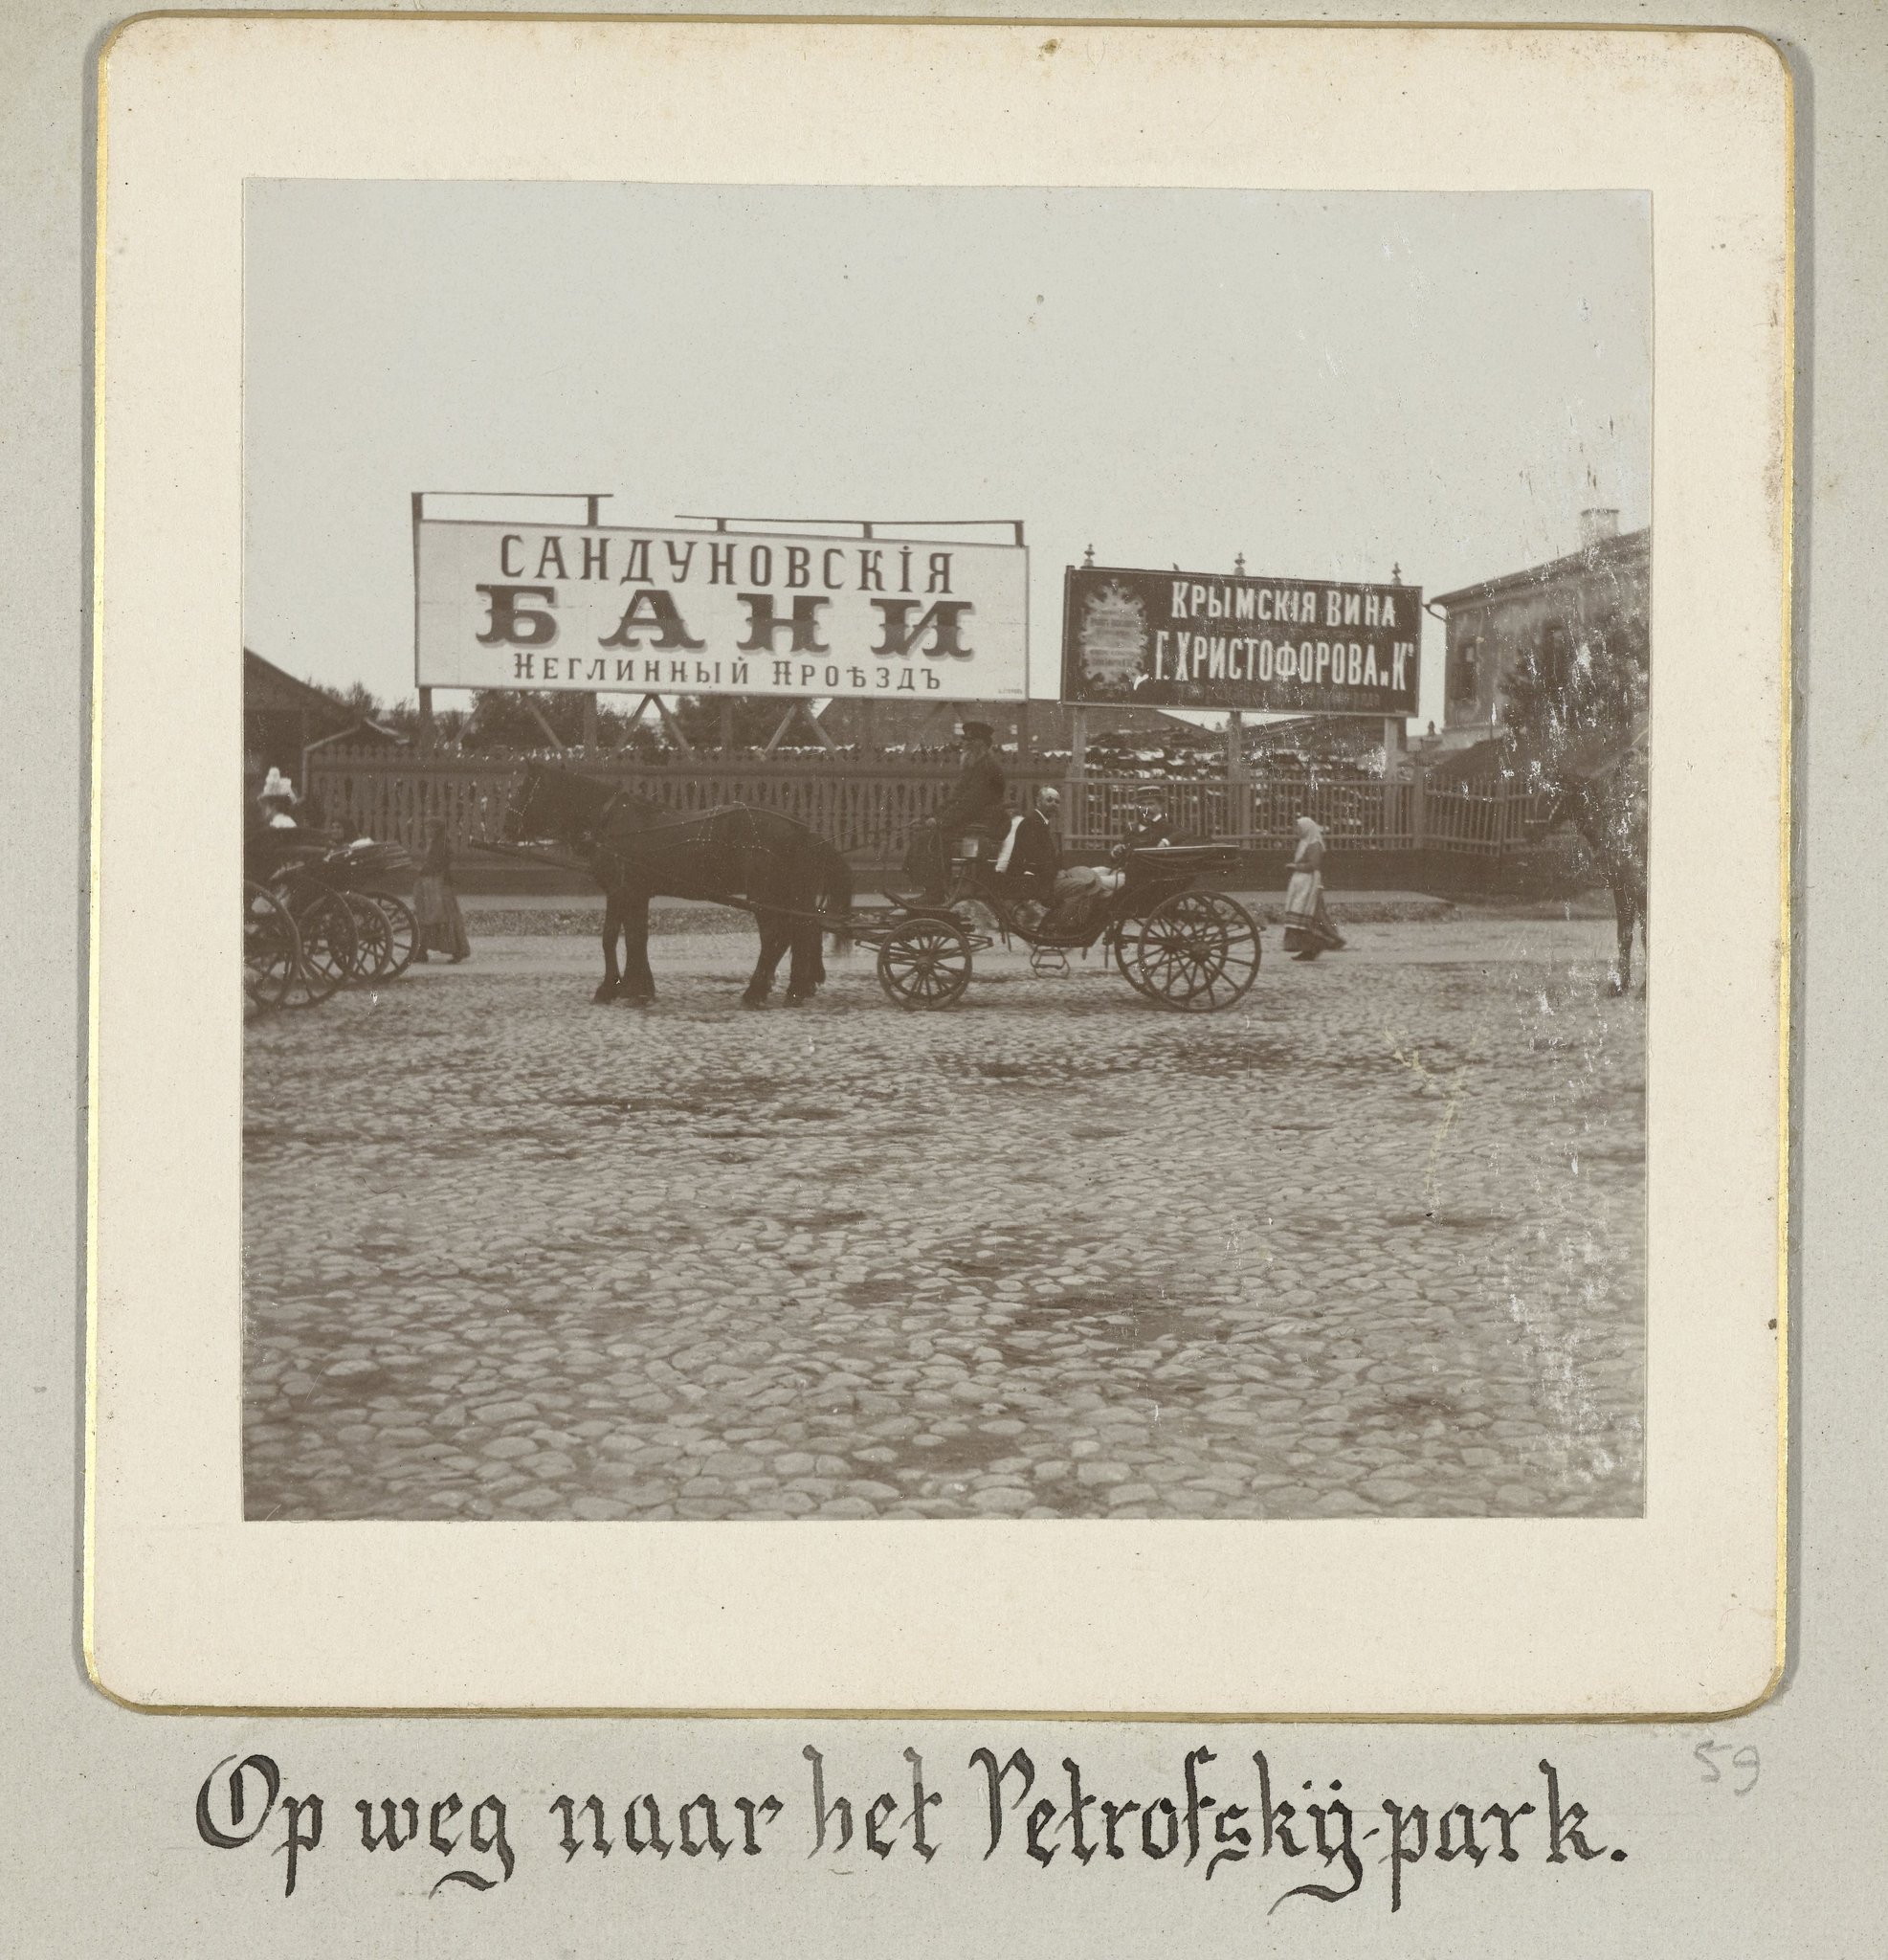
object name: photograph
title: Op weg naar Petrofskij park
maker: henry pauw van wieldrecht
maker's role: fotograaf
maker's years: 1863-1912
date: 1898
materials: paper, photographic support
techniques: albumen print